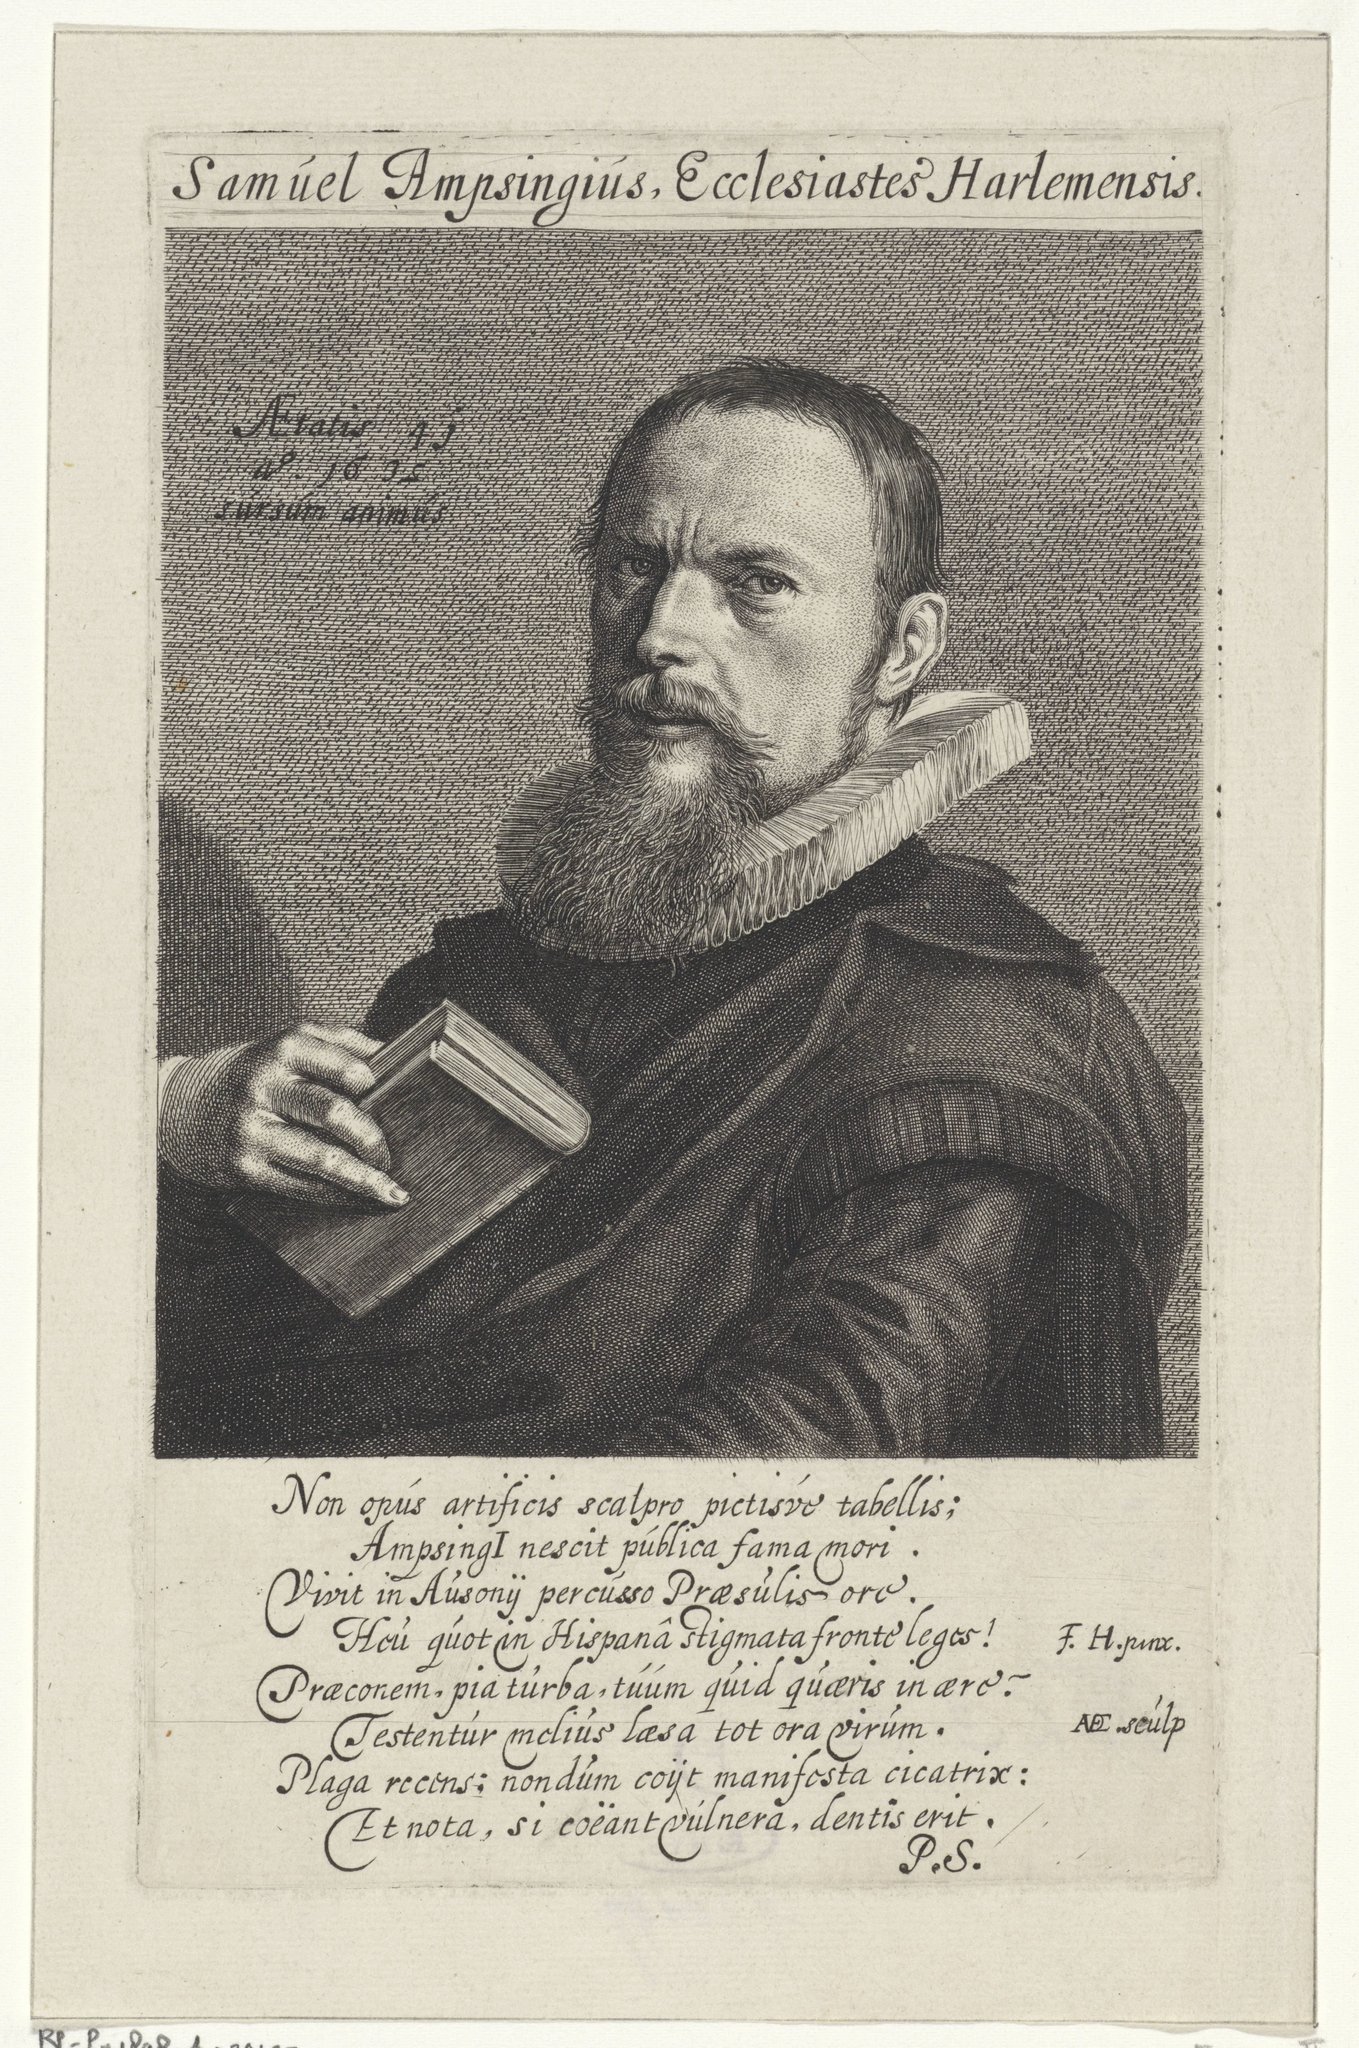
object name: print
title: Portret van Samuel Ampzing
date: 1632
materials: paper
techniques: engraving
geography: northern netherlands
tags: haarlem, samuel ampzing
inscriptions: monogram: ‘P.S.’ Petrus Scriverius, inscription: ‘Samuel Ampsingiu, Ecclesiaticus Harlemen’, caption: ‘Non opus artificis...dentis erit’, collector's mark: Lugt 964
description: Portret van Samuel Ampzing, predikant en dichter in Haarlem, op 41-jarige leeftijd.